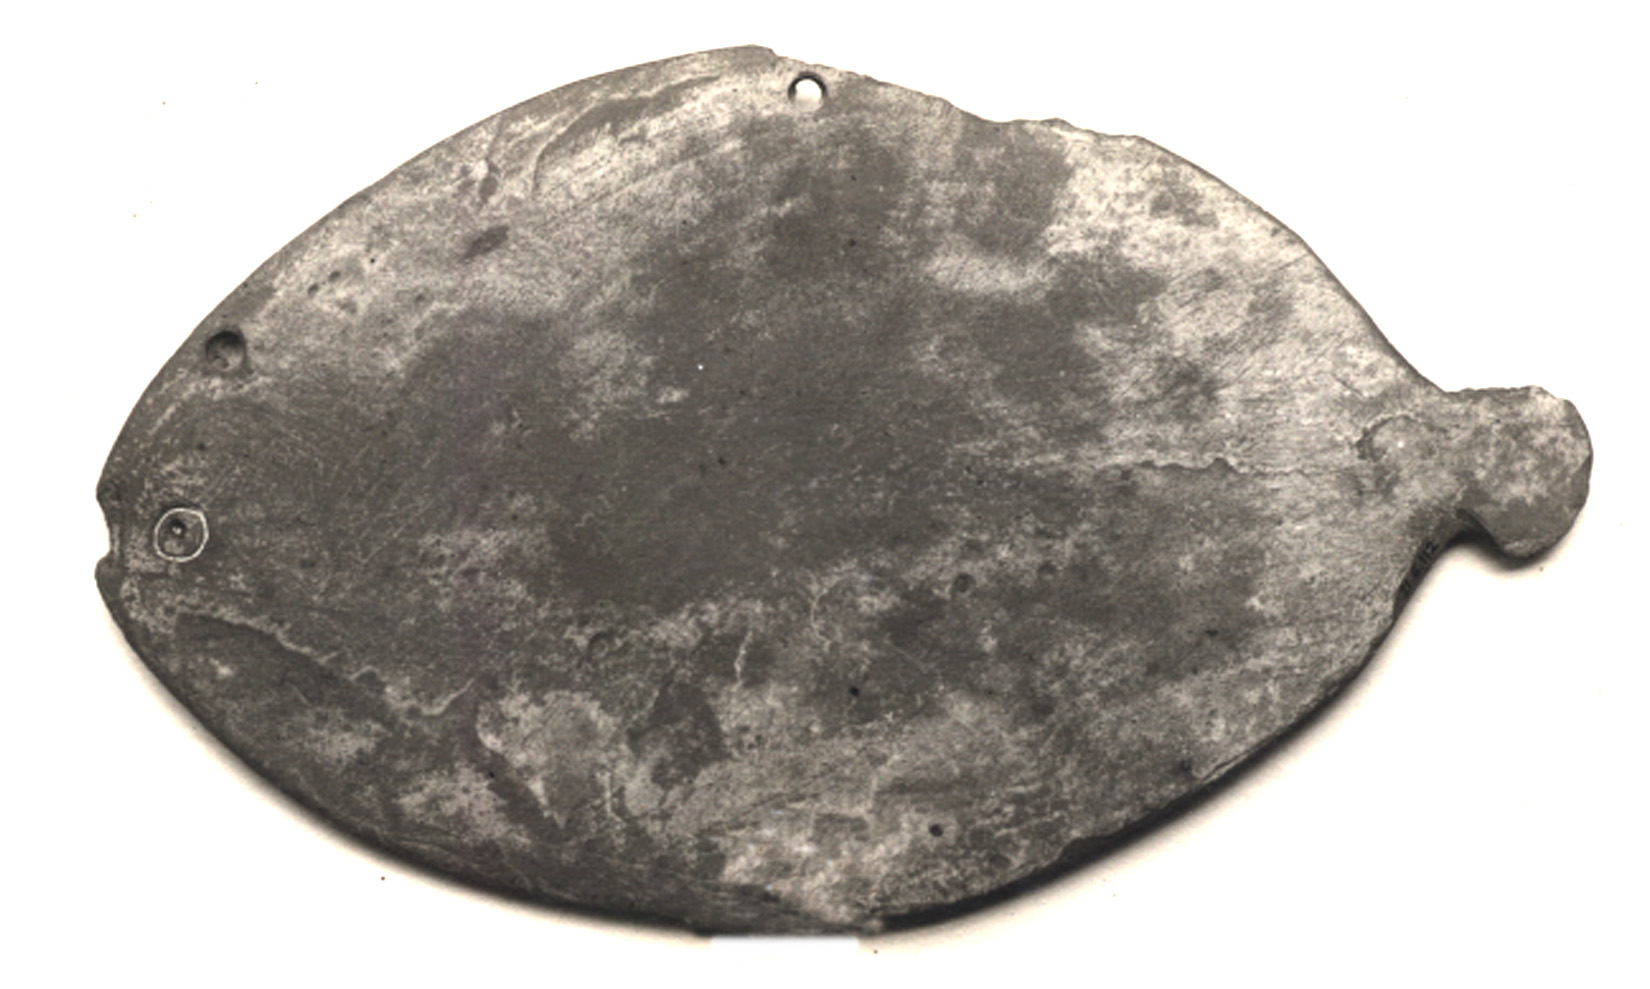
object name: palette, fish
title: Fish palette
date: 3650-3500 BCE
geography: egypt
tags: fish